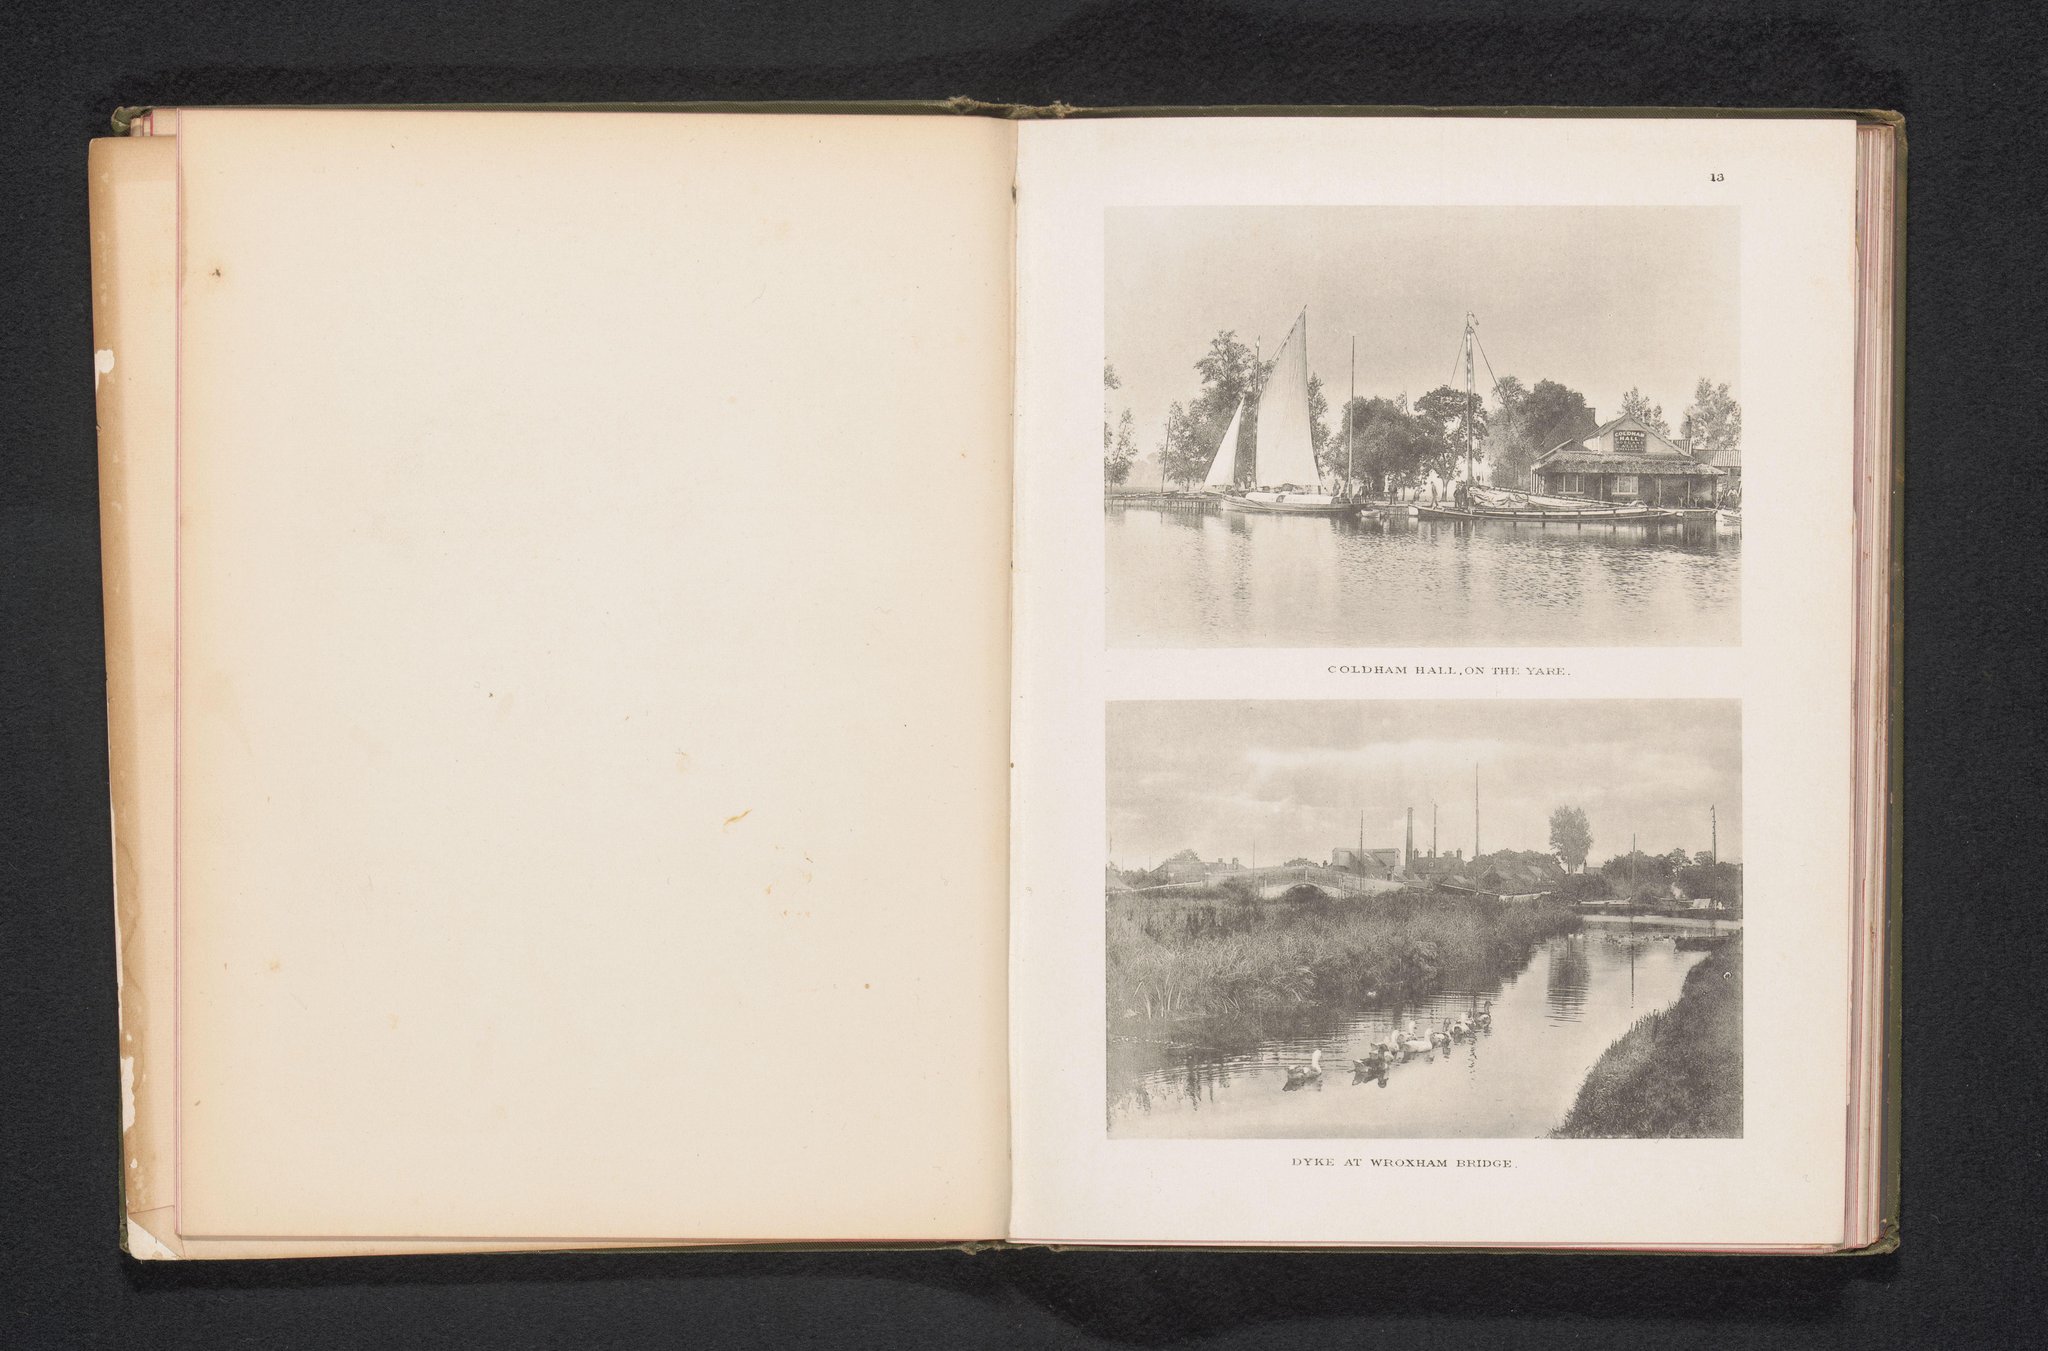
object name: photomechanical print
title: Gezicht op Coldman Hall te Surlingham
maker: john payne jennings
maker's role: fotograaf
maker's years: 1843-1926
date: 1886-1891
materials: paper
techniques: photograph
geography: surlingham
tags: sailing-ship, sailing-boat, river, restaurant